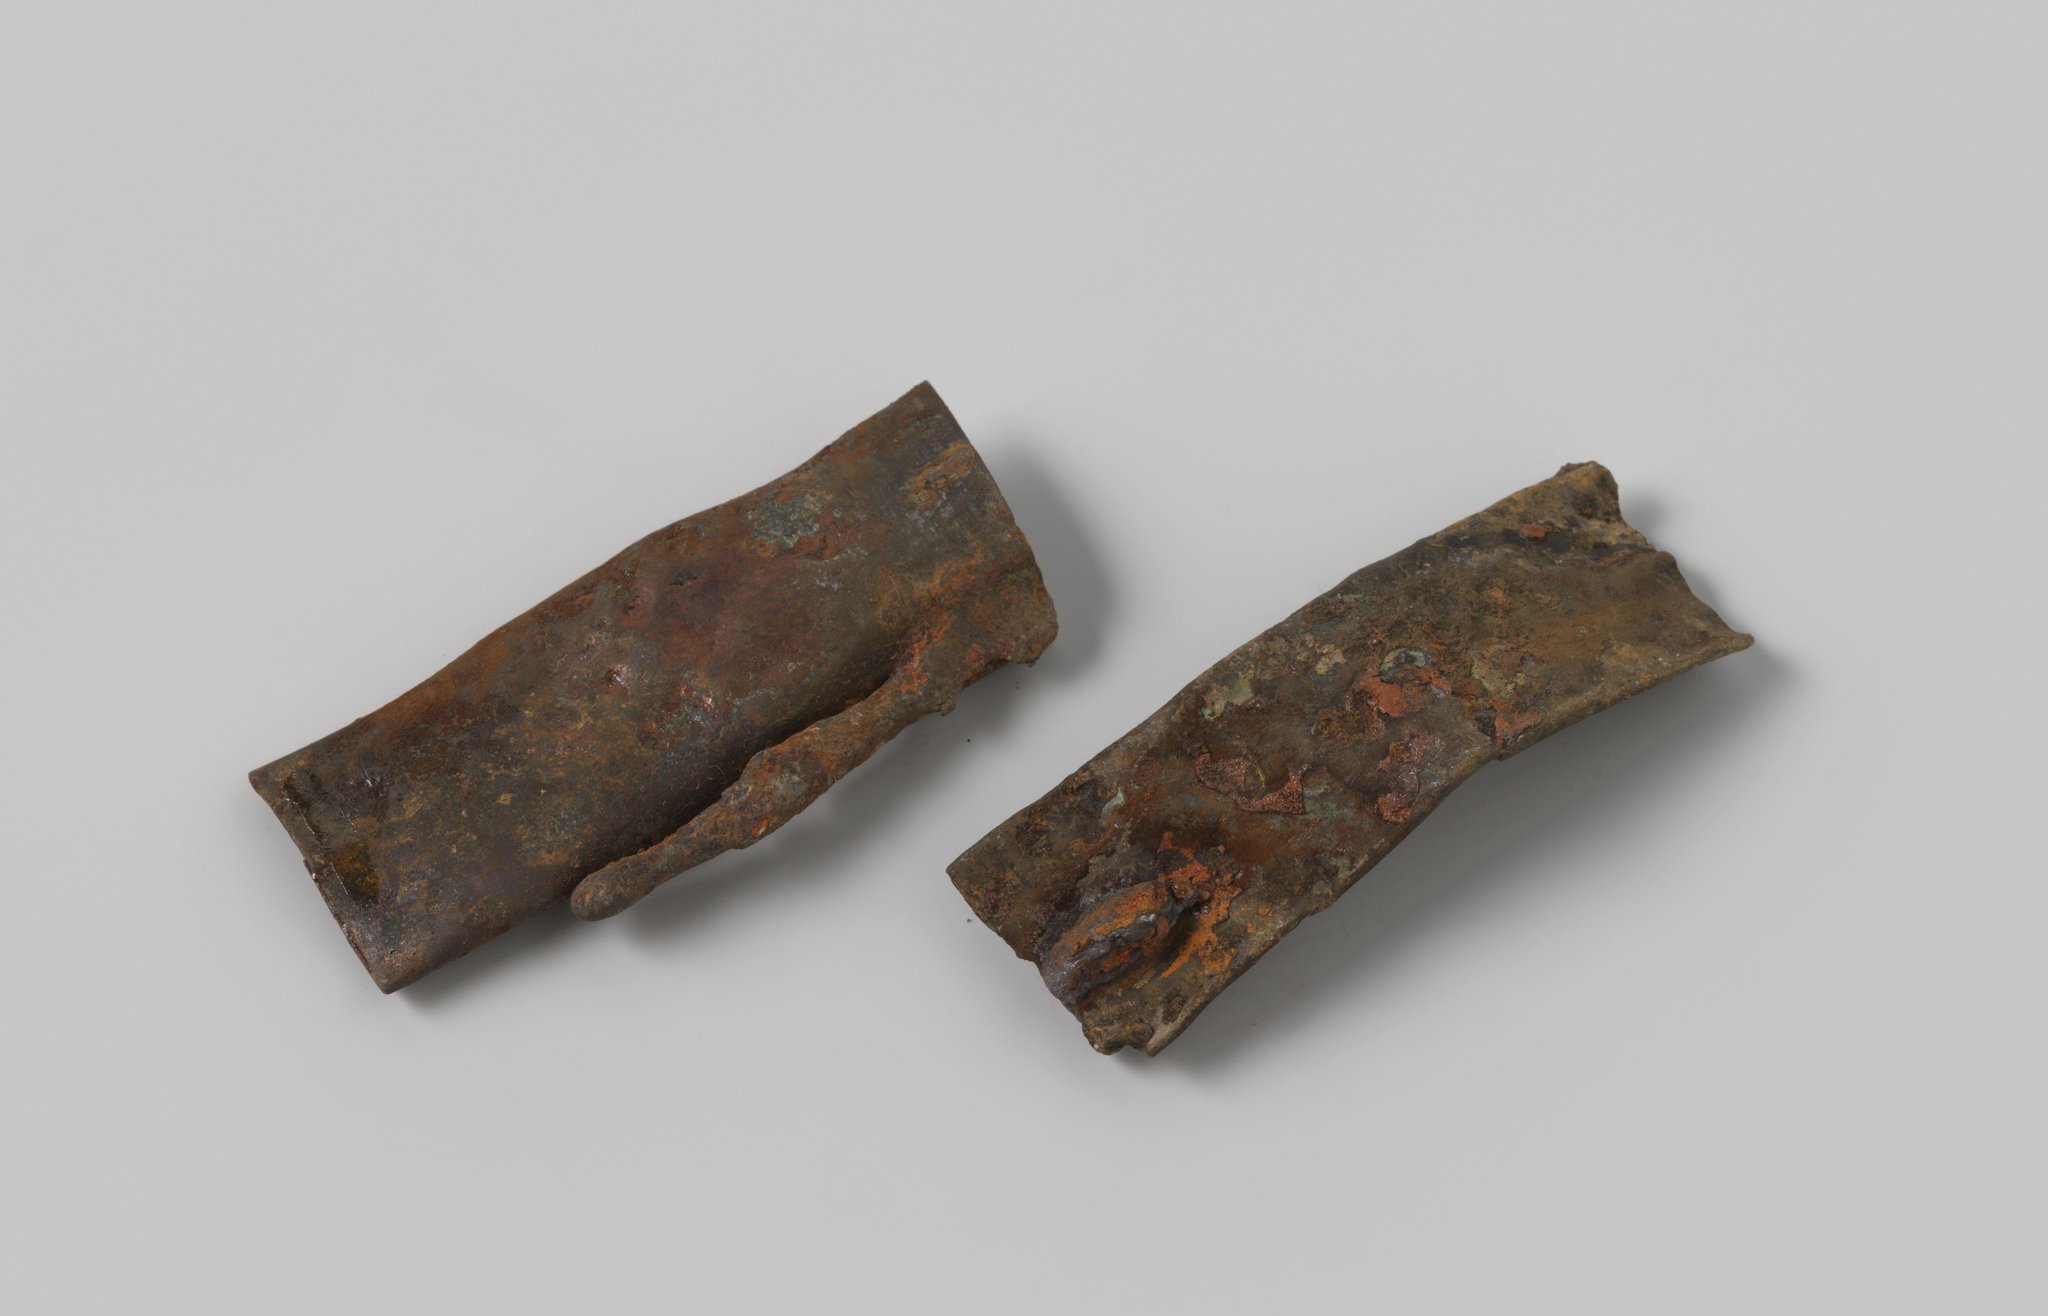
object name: cartridge shell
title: Patroonhulzen met beslag uit het wrak van de Oost-Indiëvaarder Hollandia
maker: Anonymous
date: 1700-1743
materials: copper, lead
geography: netherlands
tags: verenigde oostindische compagnie, hollandia (schip), annet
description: Cartridge case, tube; squashed, id. NG 1979-205H549 with lead solder fragm.